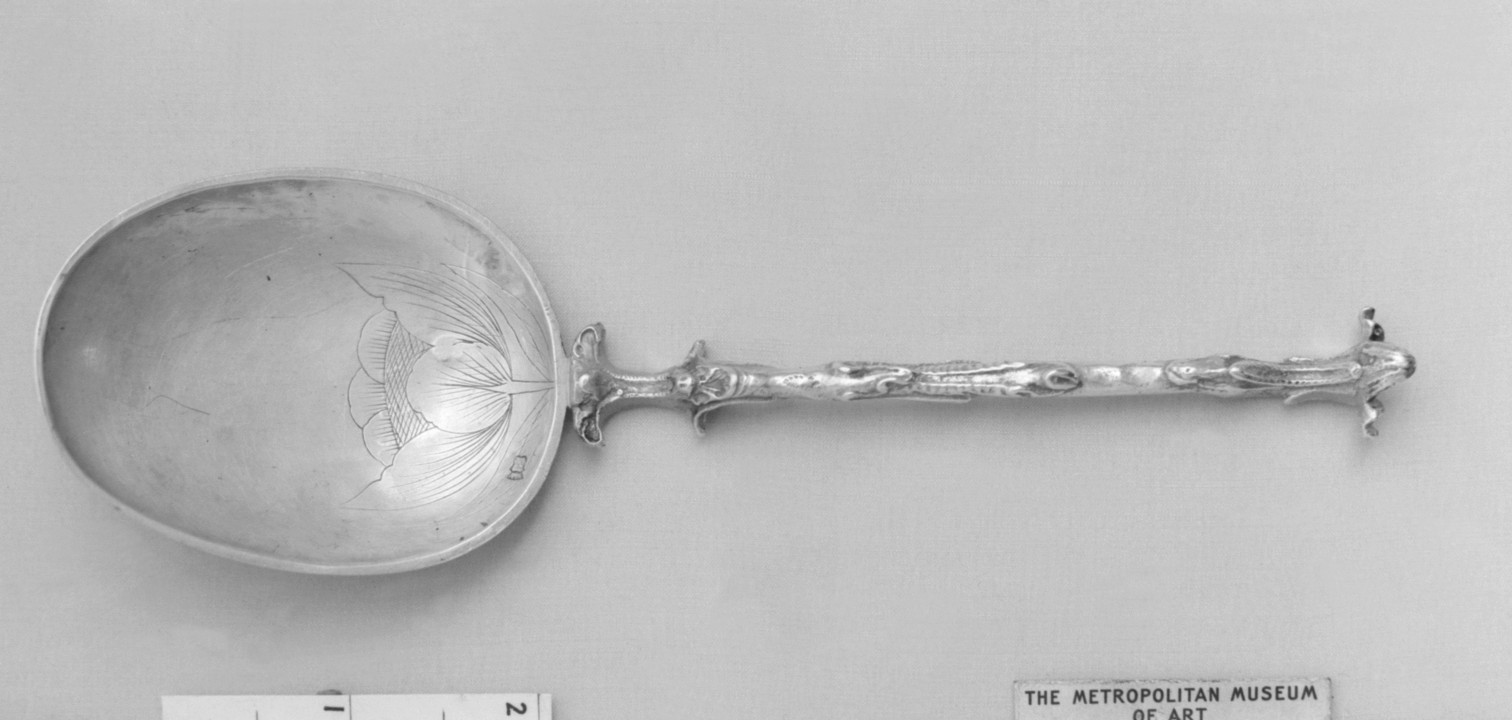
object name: spoon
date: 1667-1700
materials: silver